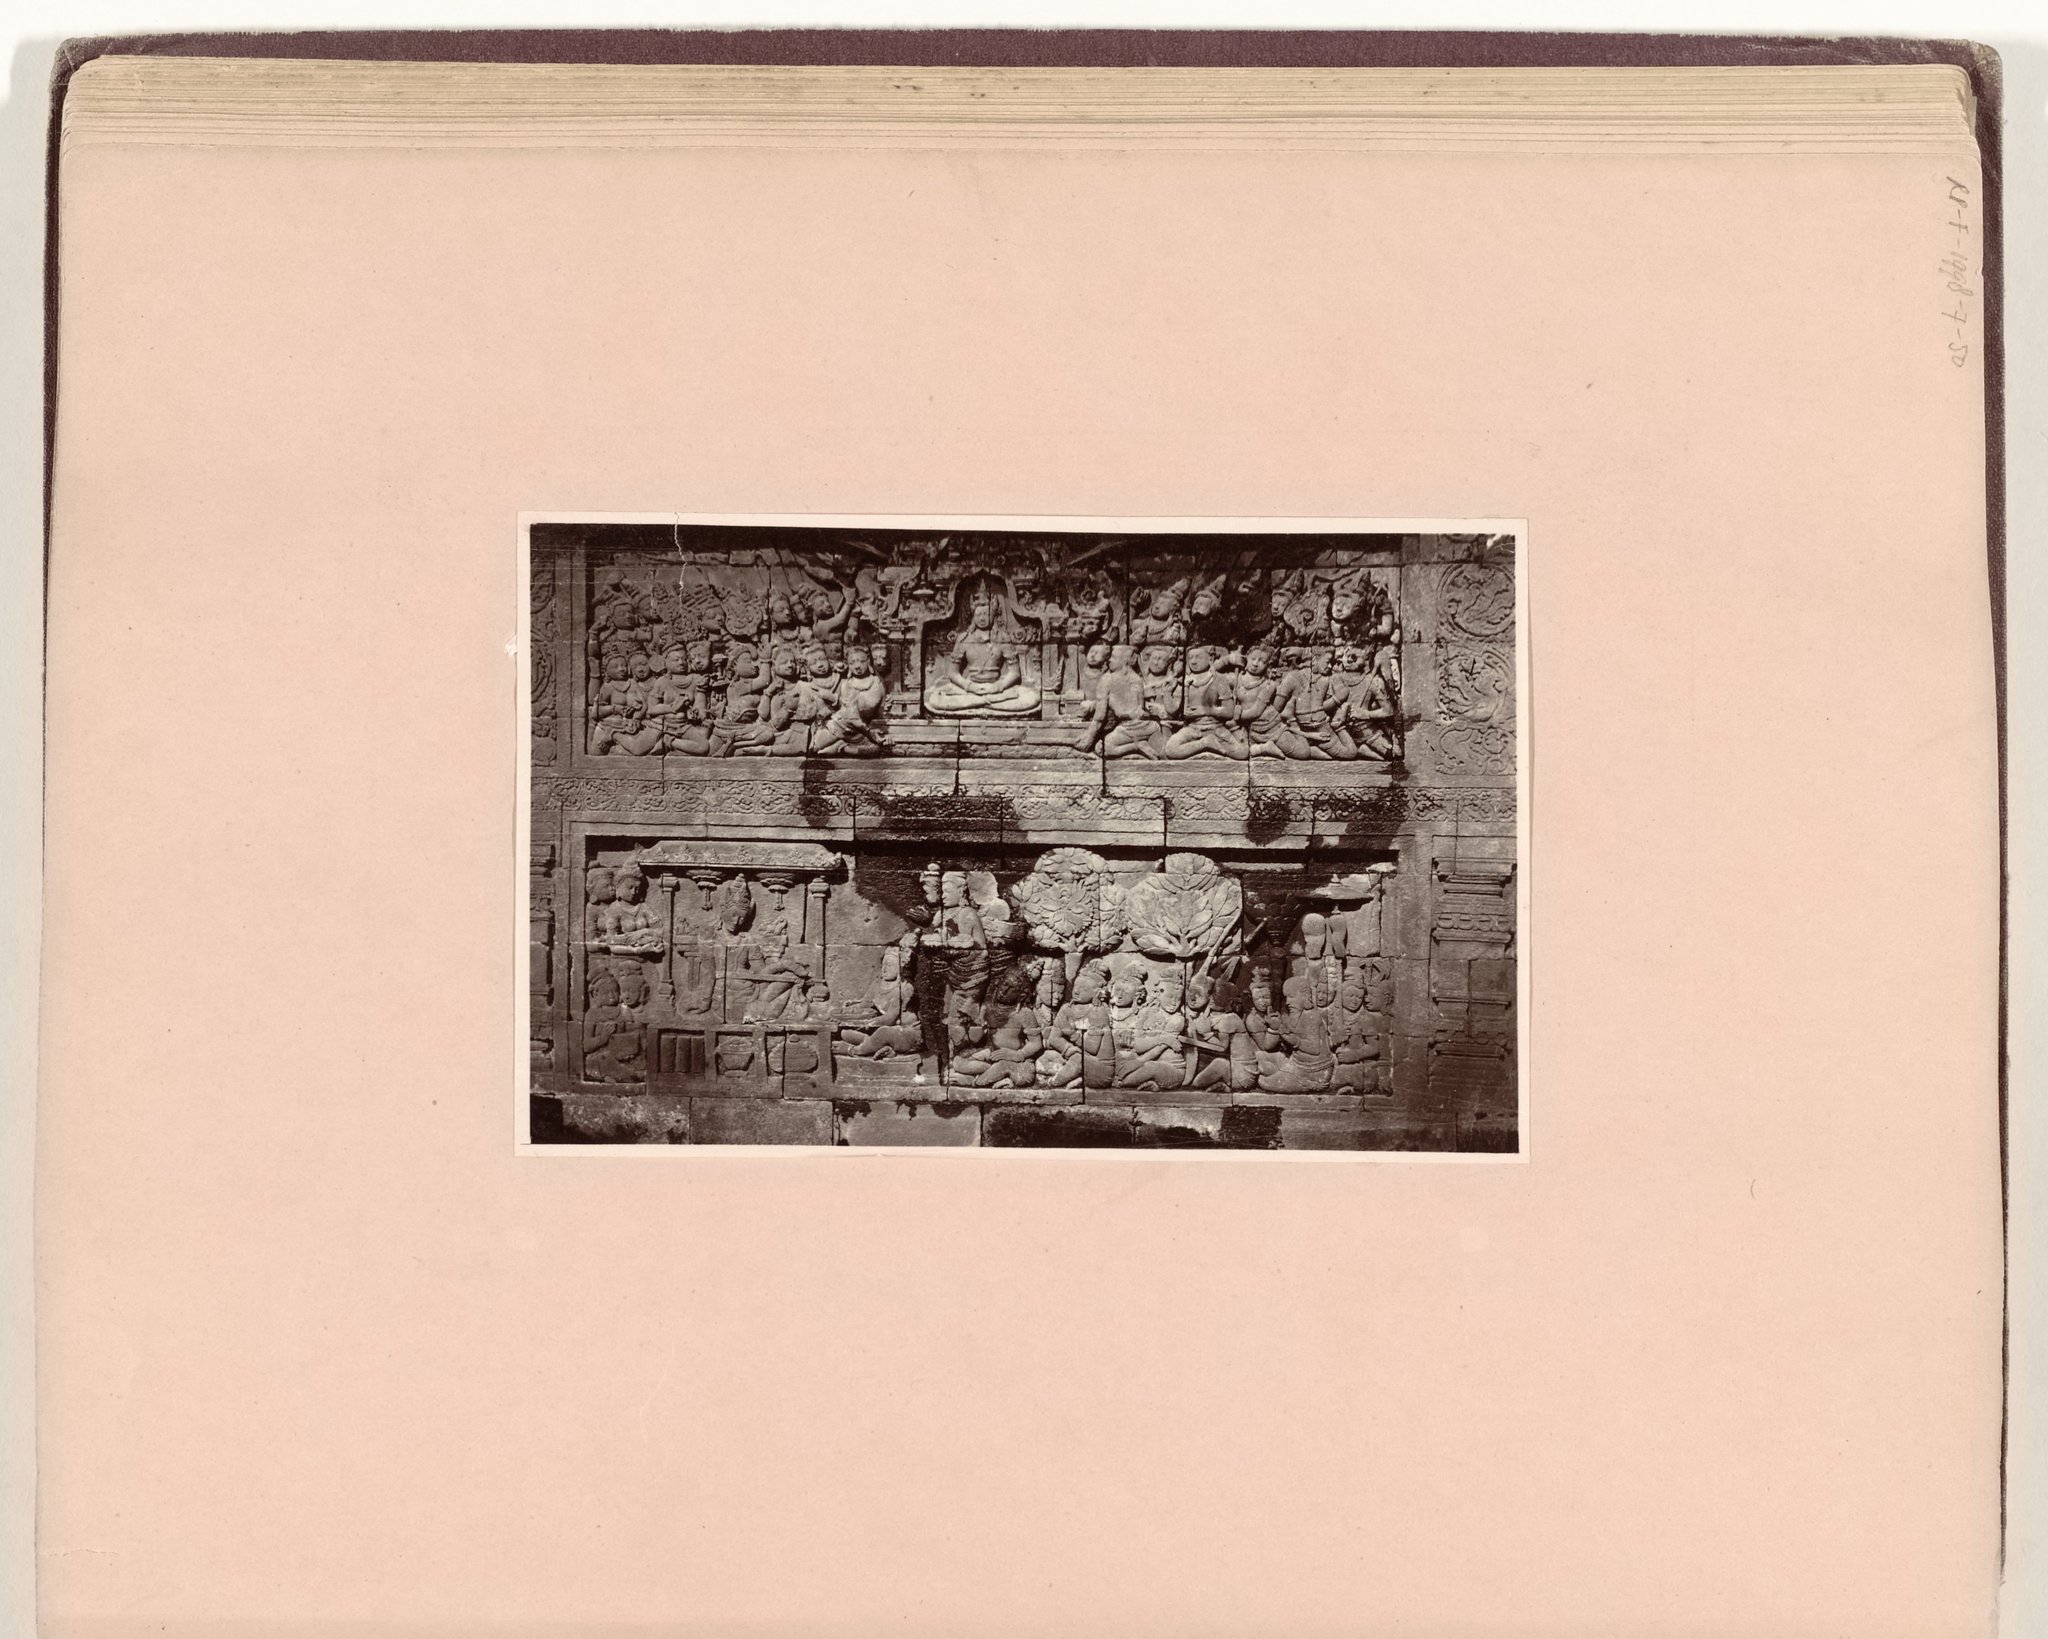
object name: photograph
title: Reliëfs van de Borobudur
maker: c. dietrich (fotograaf)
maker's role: fotograaf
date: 1875-1890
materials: cardboard, paper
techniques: albumen print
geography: java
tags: sculpture (+ relief ~ sculpture)